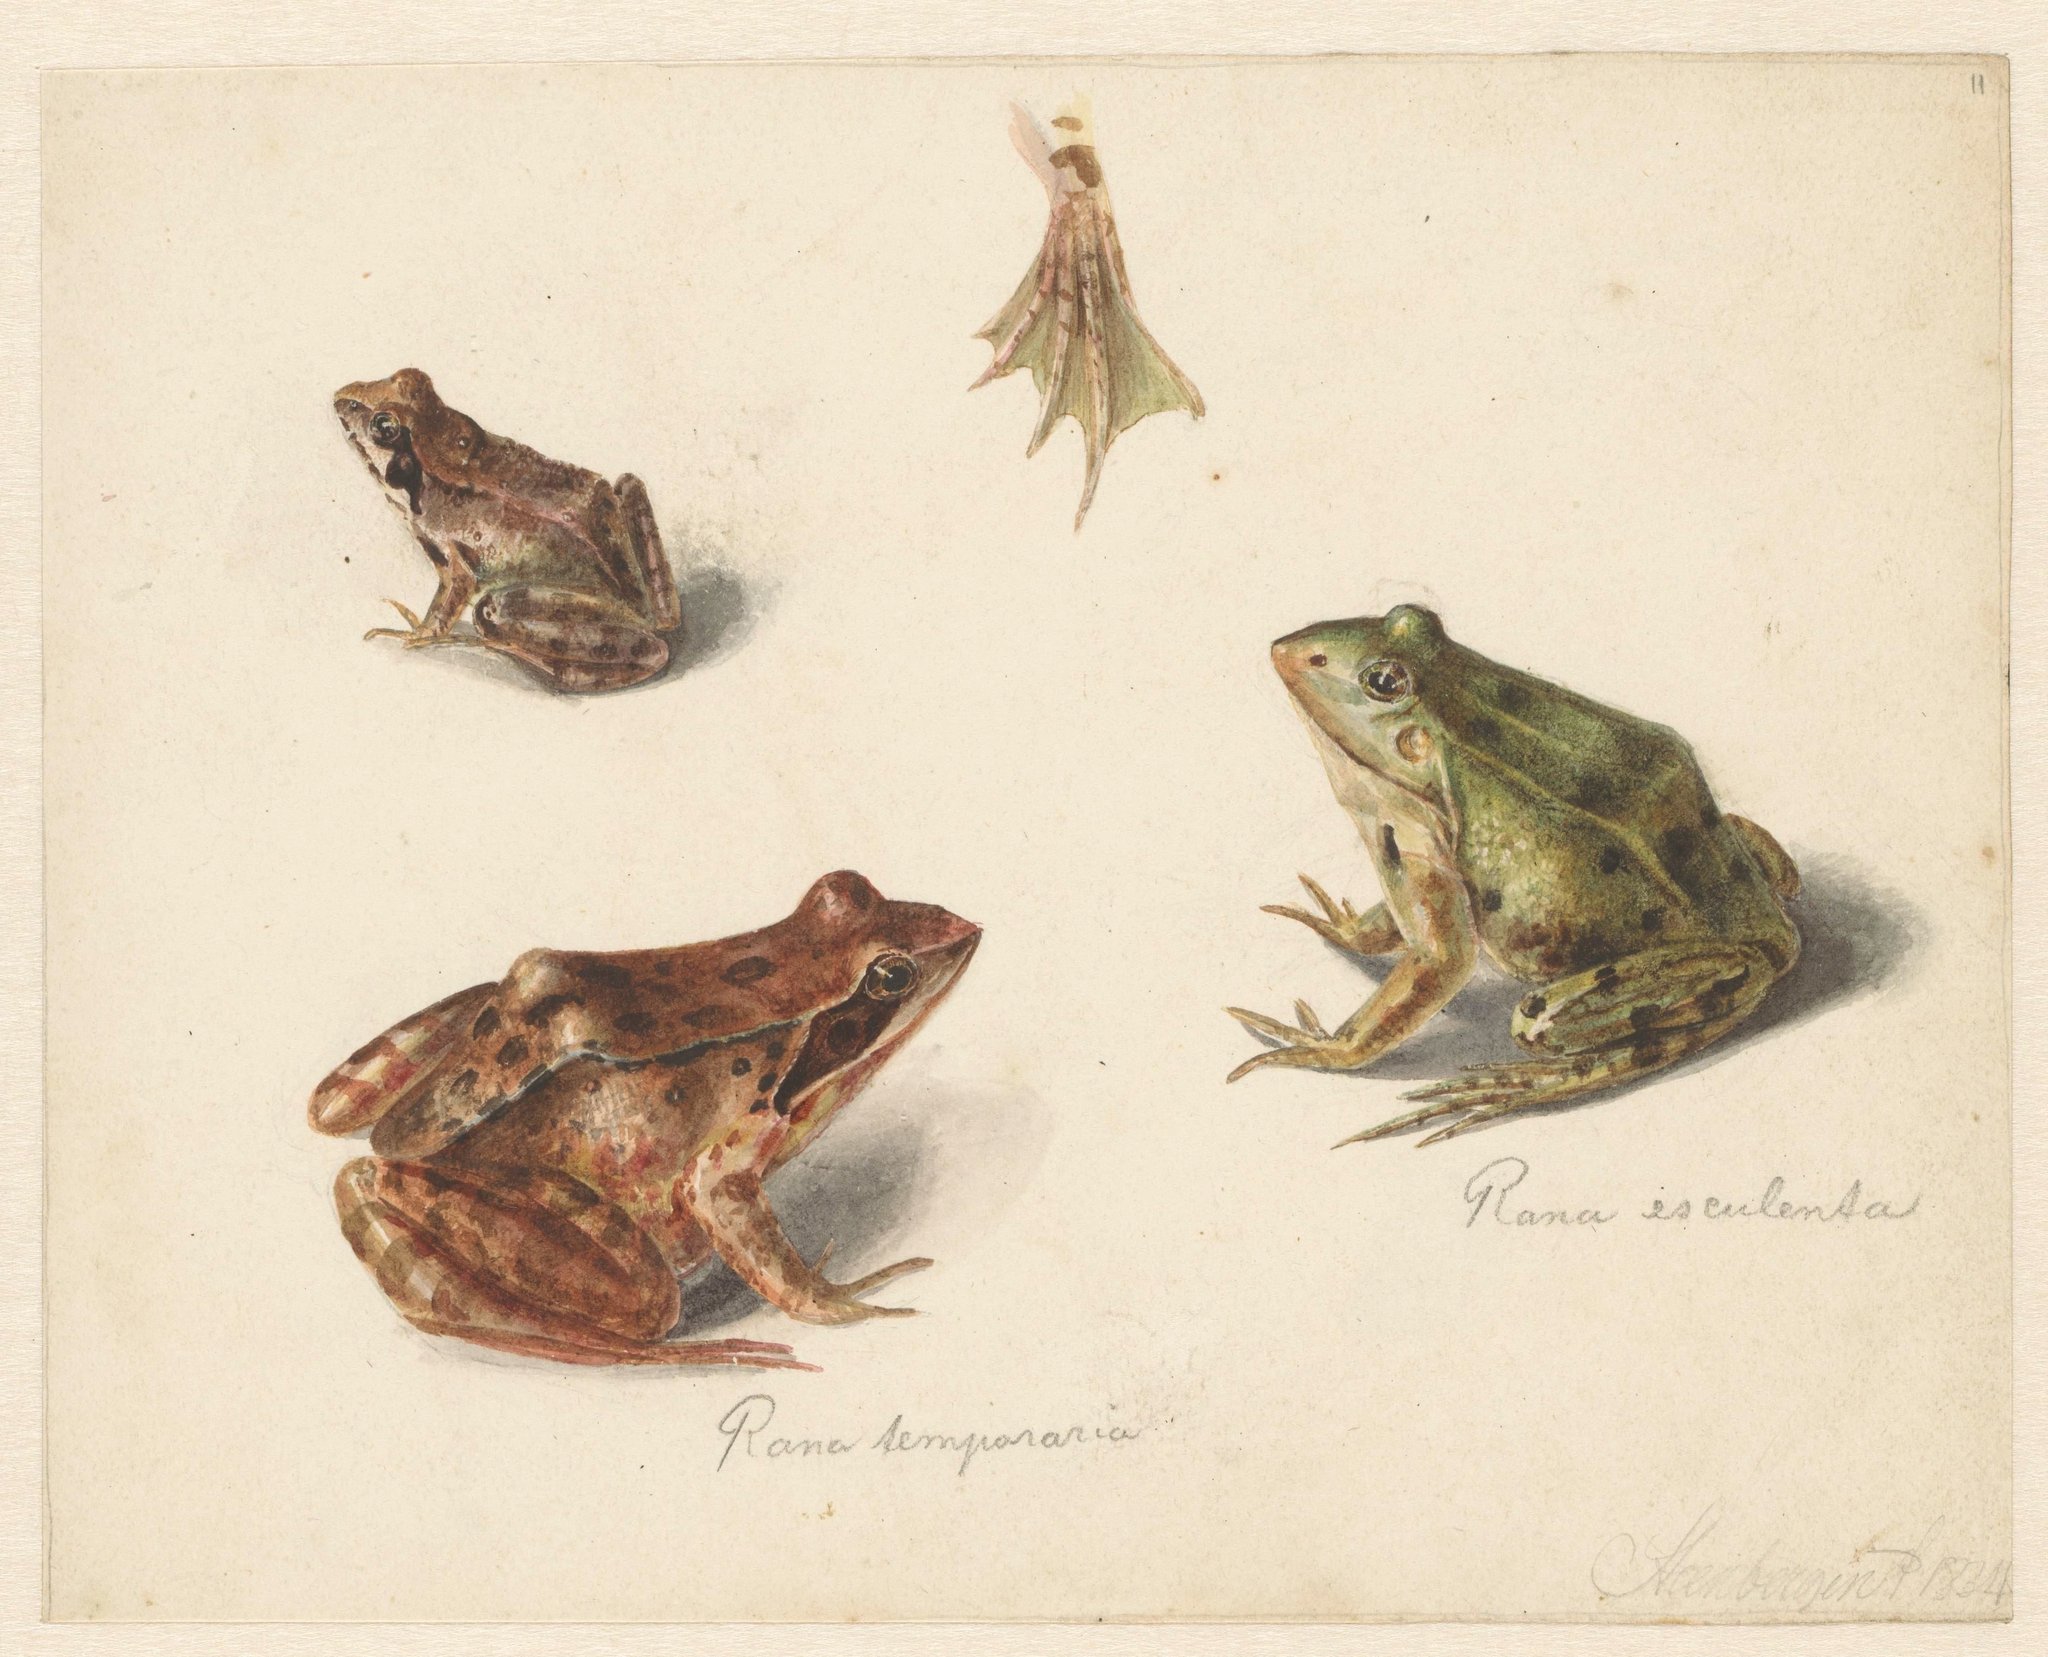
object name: drawing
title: Blad met studie van een bruine landkikker rechts, links een groene waterkikker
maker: albertus steenbergen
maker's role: draughtsman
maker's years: 1814-1900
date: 1834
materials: paper, pencil, watercolor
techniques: brush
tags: tailless amphibians: frog